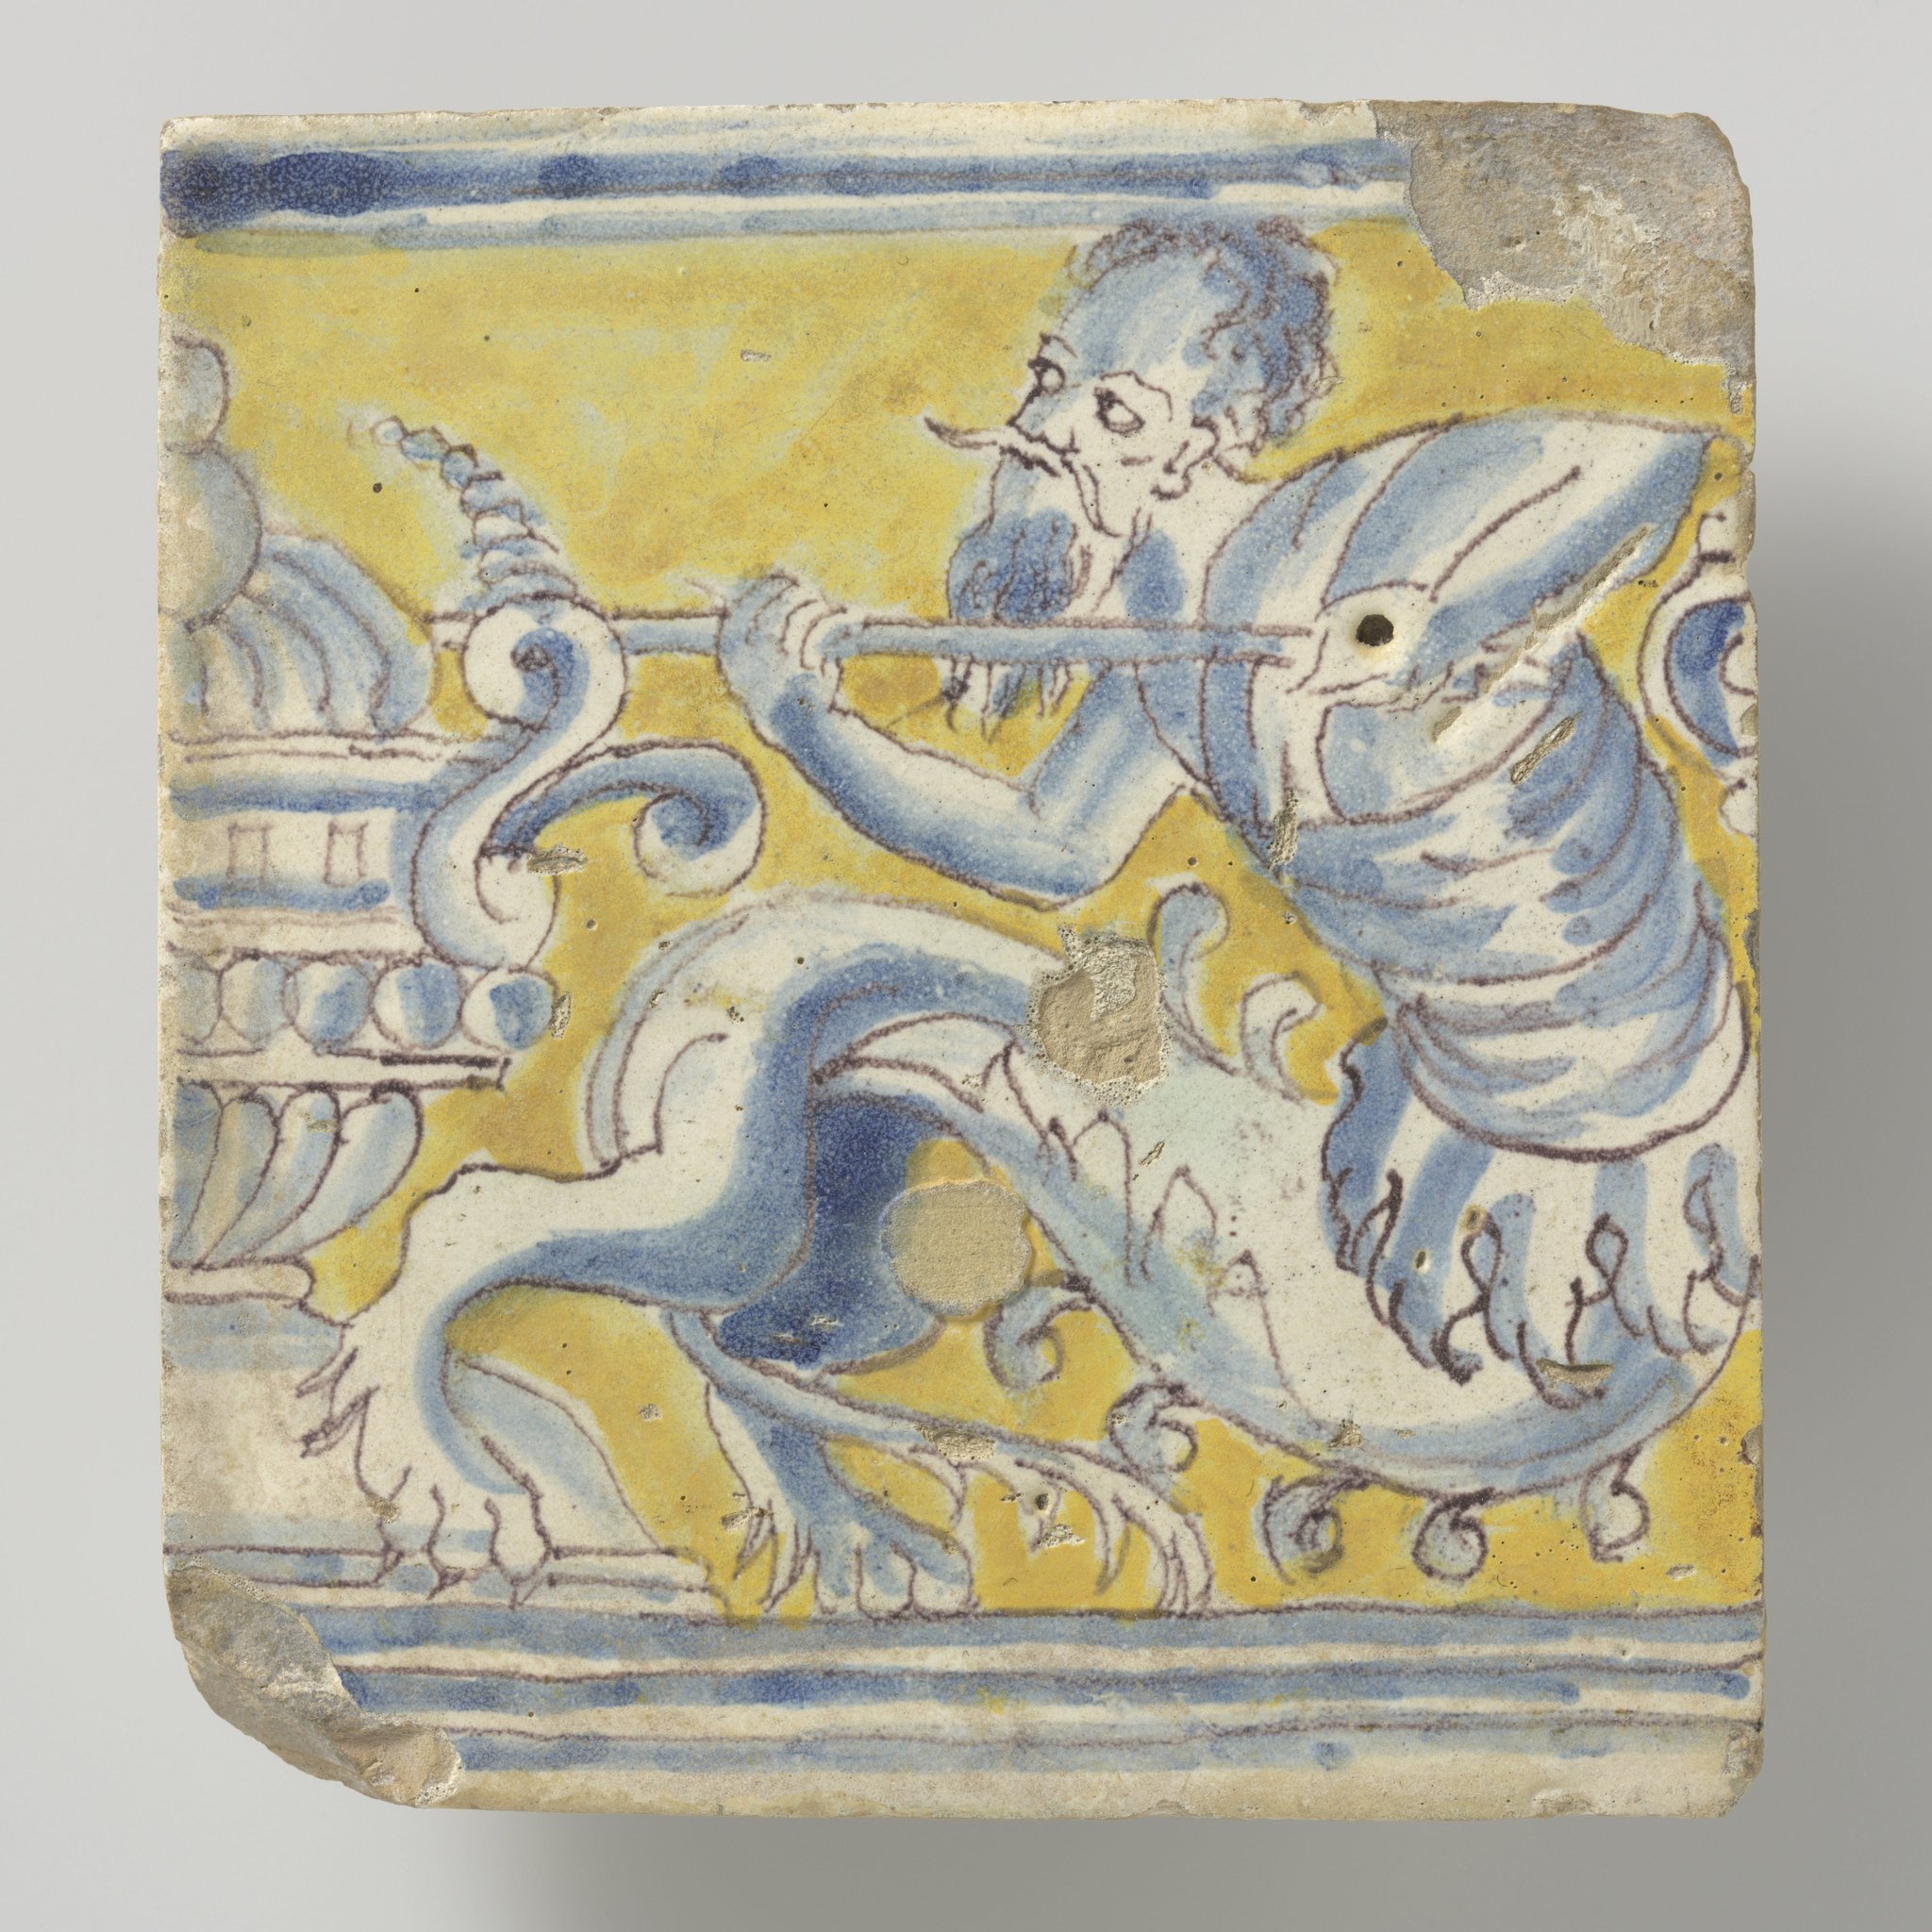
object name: tile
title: Tegel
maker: Anonymous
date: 1530-1570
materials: earthenware, glaze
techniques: maiolica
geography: iberian peninsula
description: Tegel met een veelkleurig (blauw, paars en geel) wezen, half man en half leeuw rechts van een vaas.